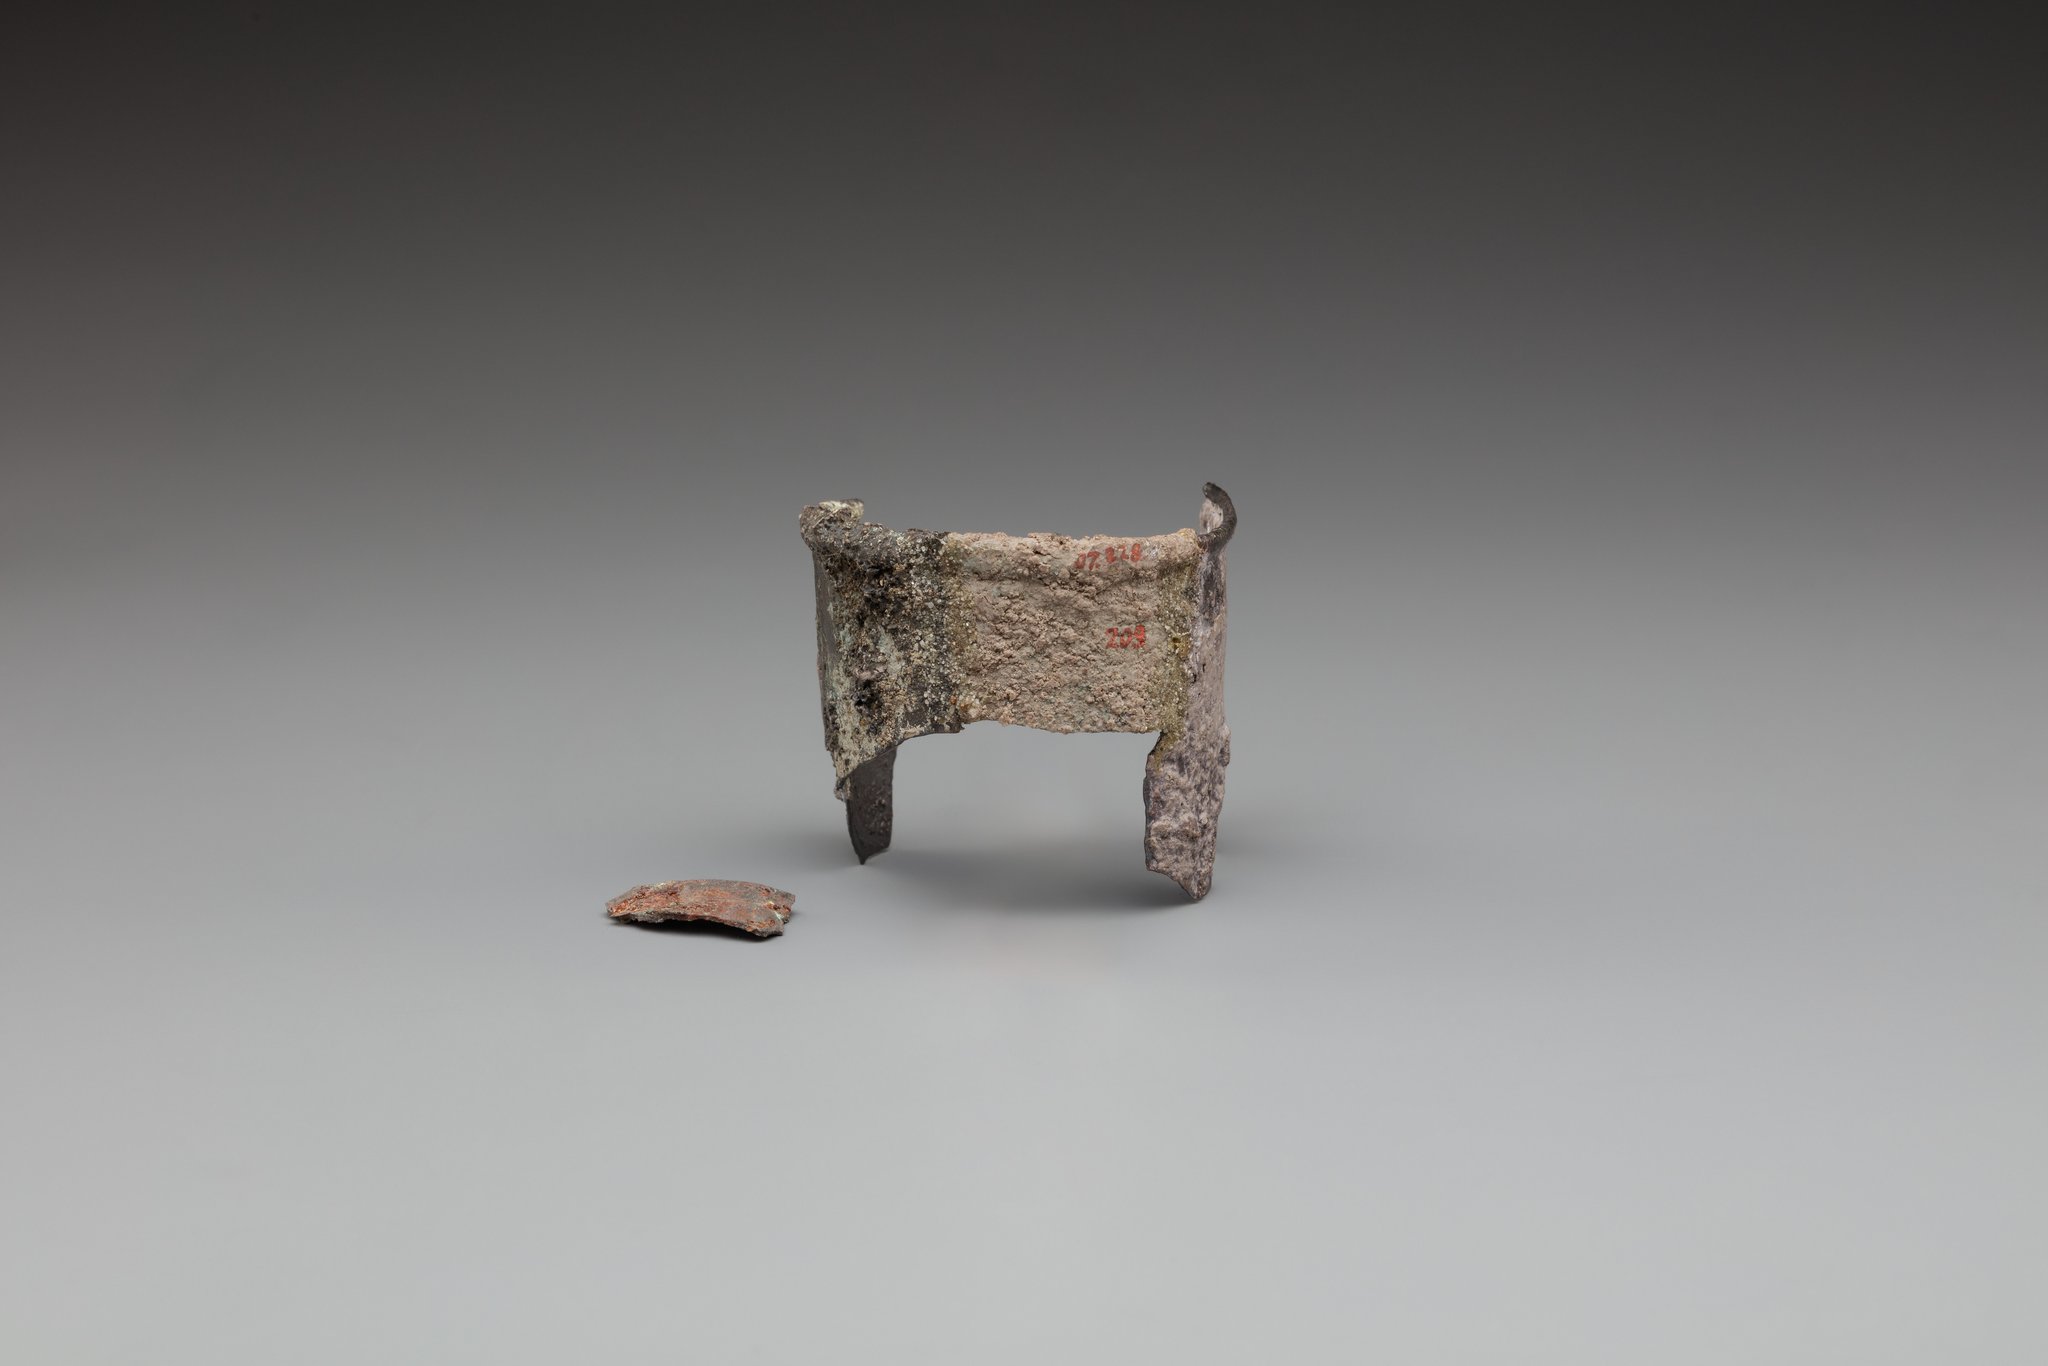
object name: situla neck fragment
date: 1295-1070 BCE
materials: silver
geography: egypt